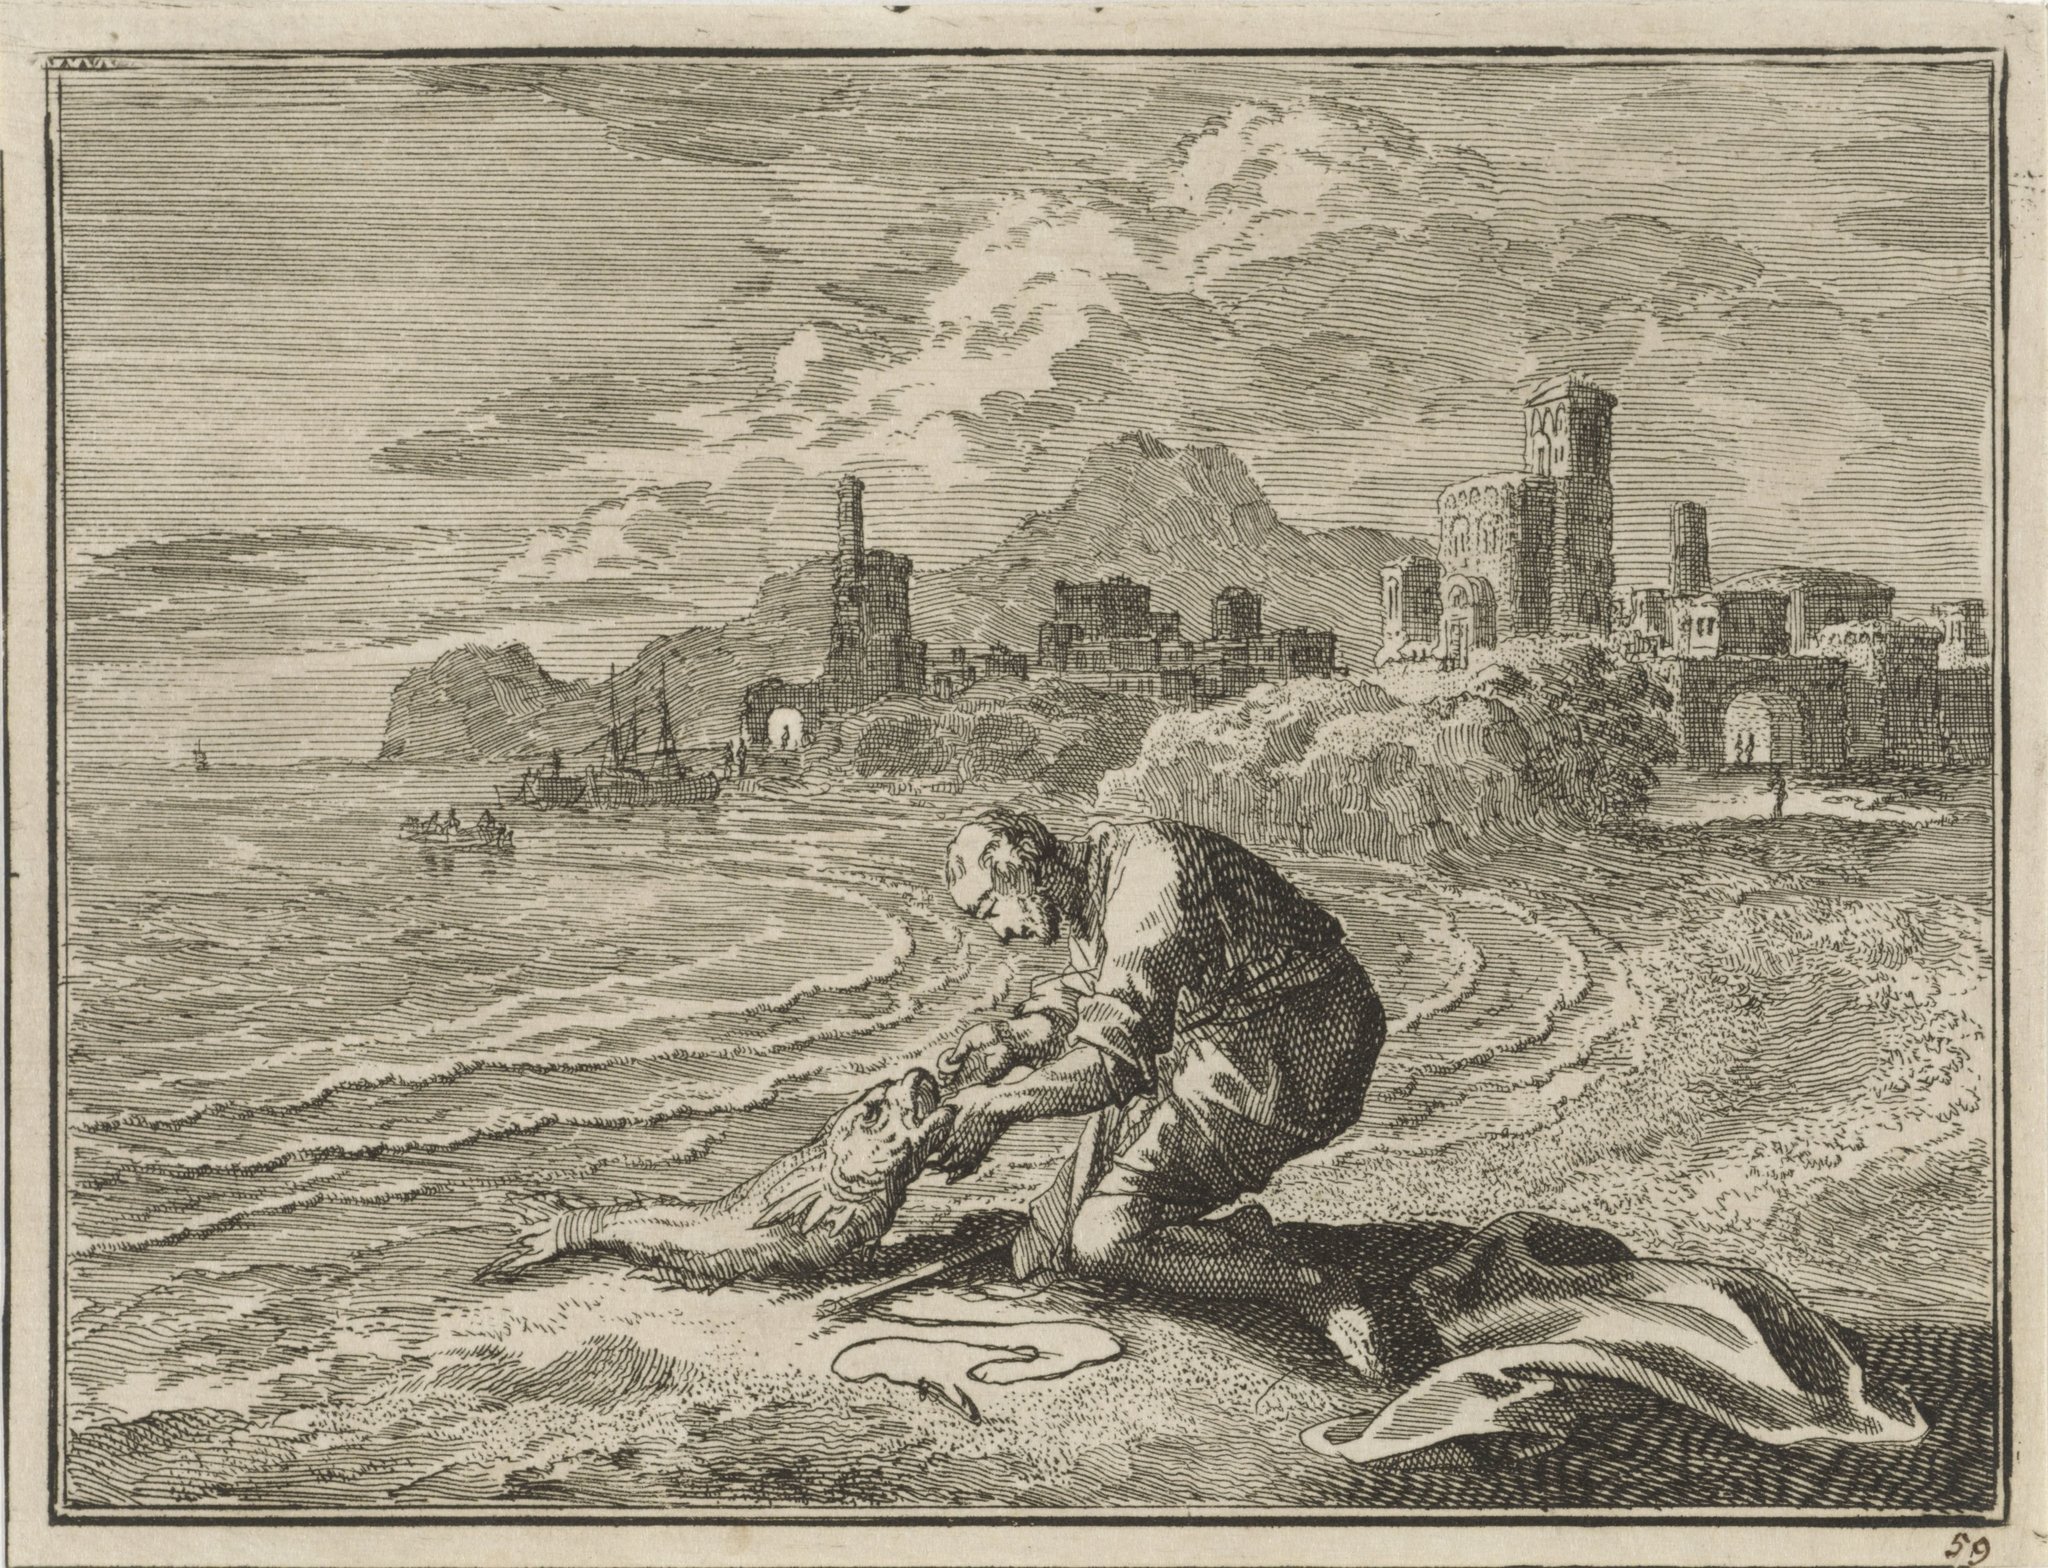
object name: print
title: Petrus vindt een munt in de bek van een vis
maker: jan luyken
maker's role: draughtsman, print maker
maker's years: 1649-1712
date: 1712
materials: paper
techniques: etching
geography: amsterdam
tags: peter finds a piece of money in the mouth of a fish and pays the temple tribute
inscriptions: number: ‘59’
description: Proefdruk van illustratie uit: Luyken, Jan. De schriftuurlyke geschiedenissen en gelykenissen van het Oude en Nieuwe Verbond, 2 delen. Amsterdam: Wed. Pieter Arentsz II en Cornelis van der Sys, 1712, dl. II.